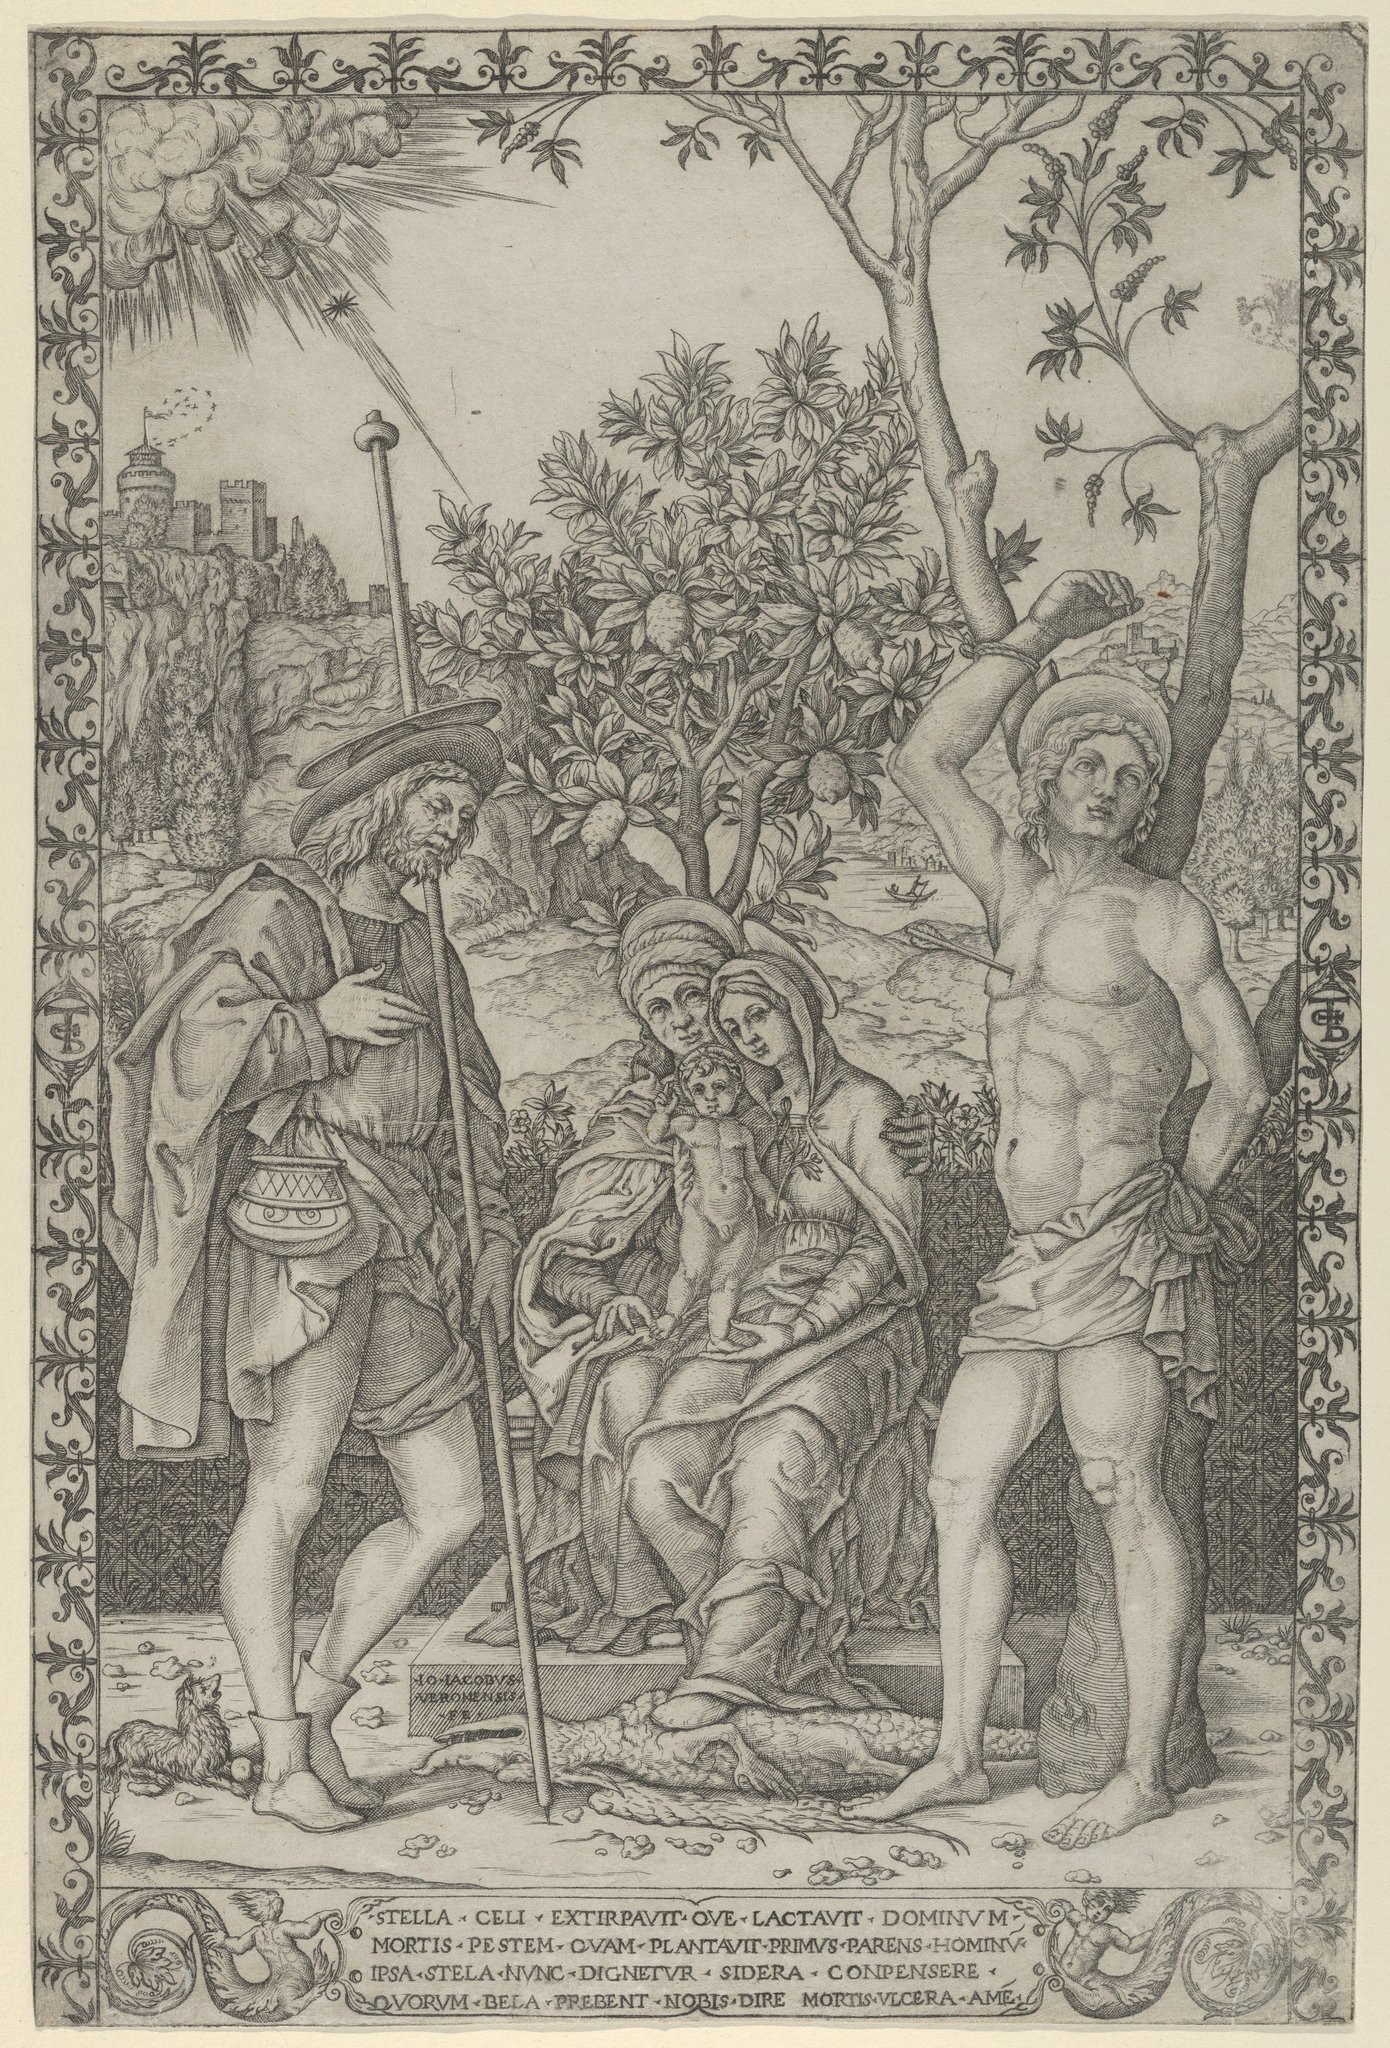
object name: print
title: The Virgin and Child on the lap of St. Anne, with St. Roch and St. Sebastian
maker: giovanni jacopo caraglio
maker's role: artist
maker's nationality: italian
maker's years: 1500-1565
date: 1517-1524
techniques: engraving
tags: men,madonna and child,saint anne